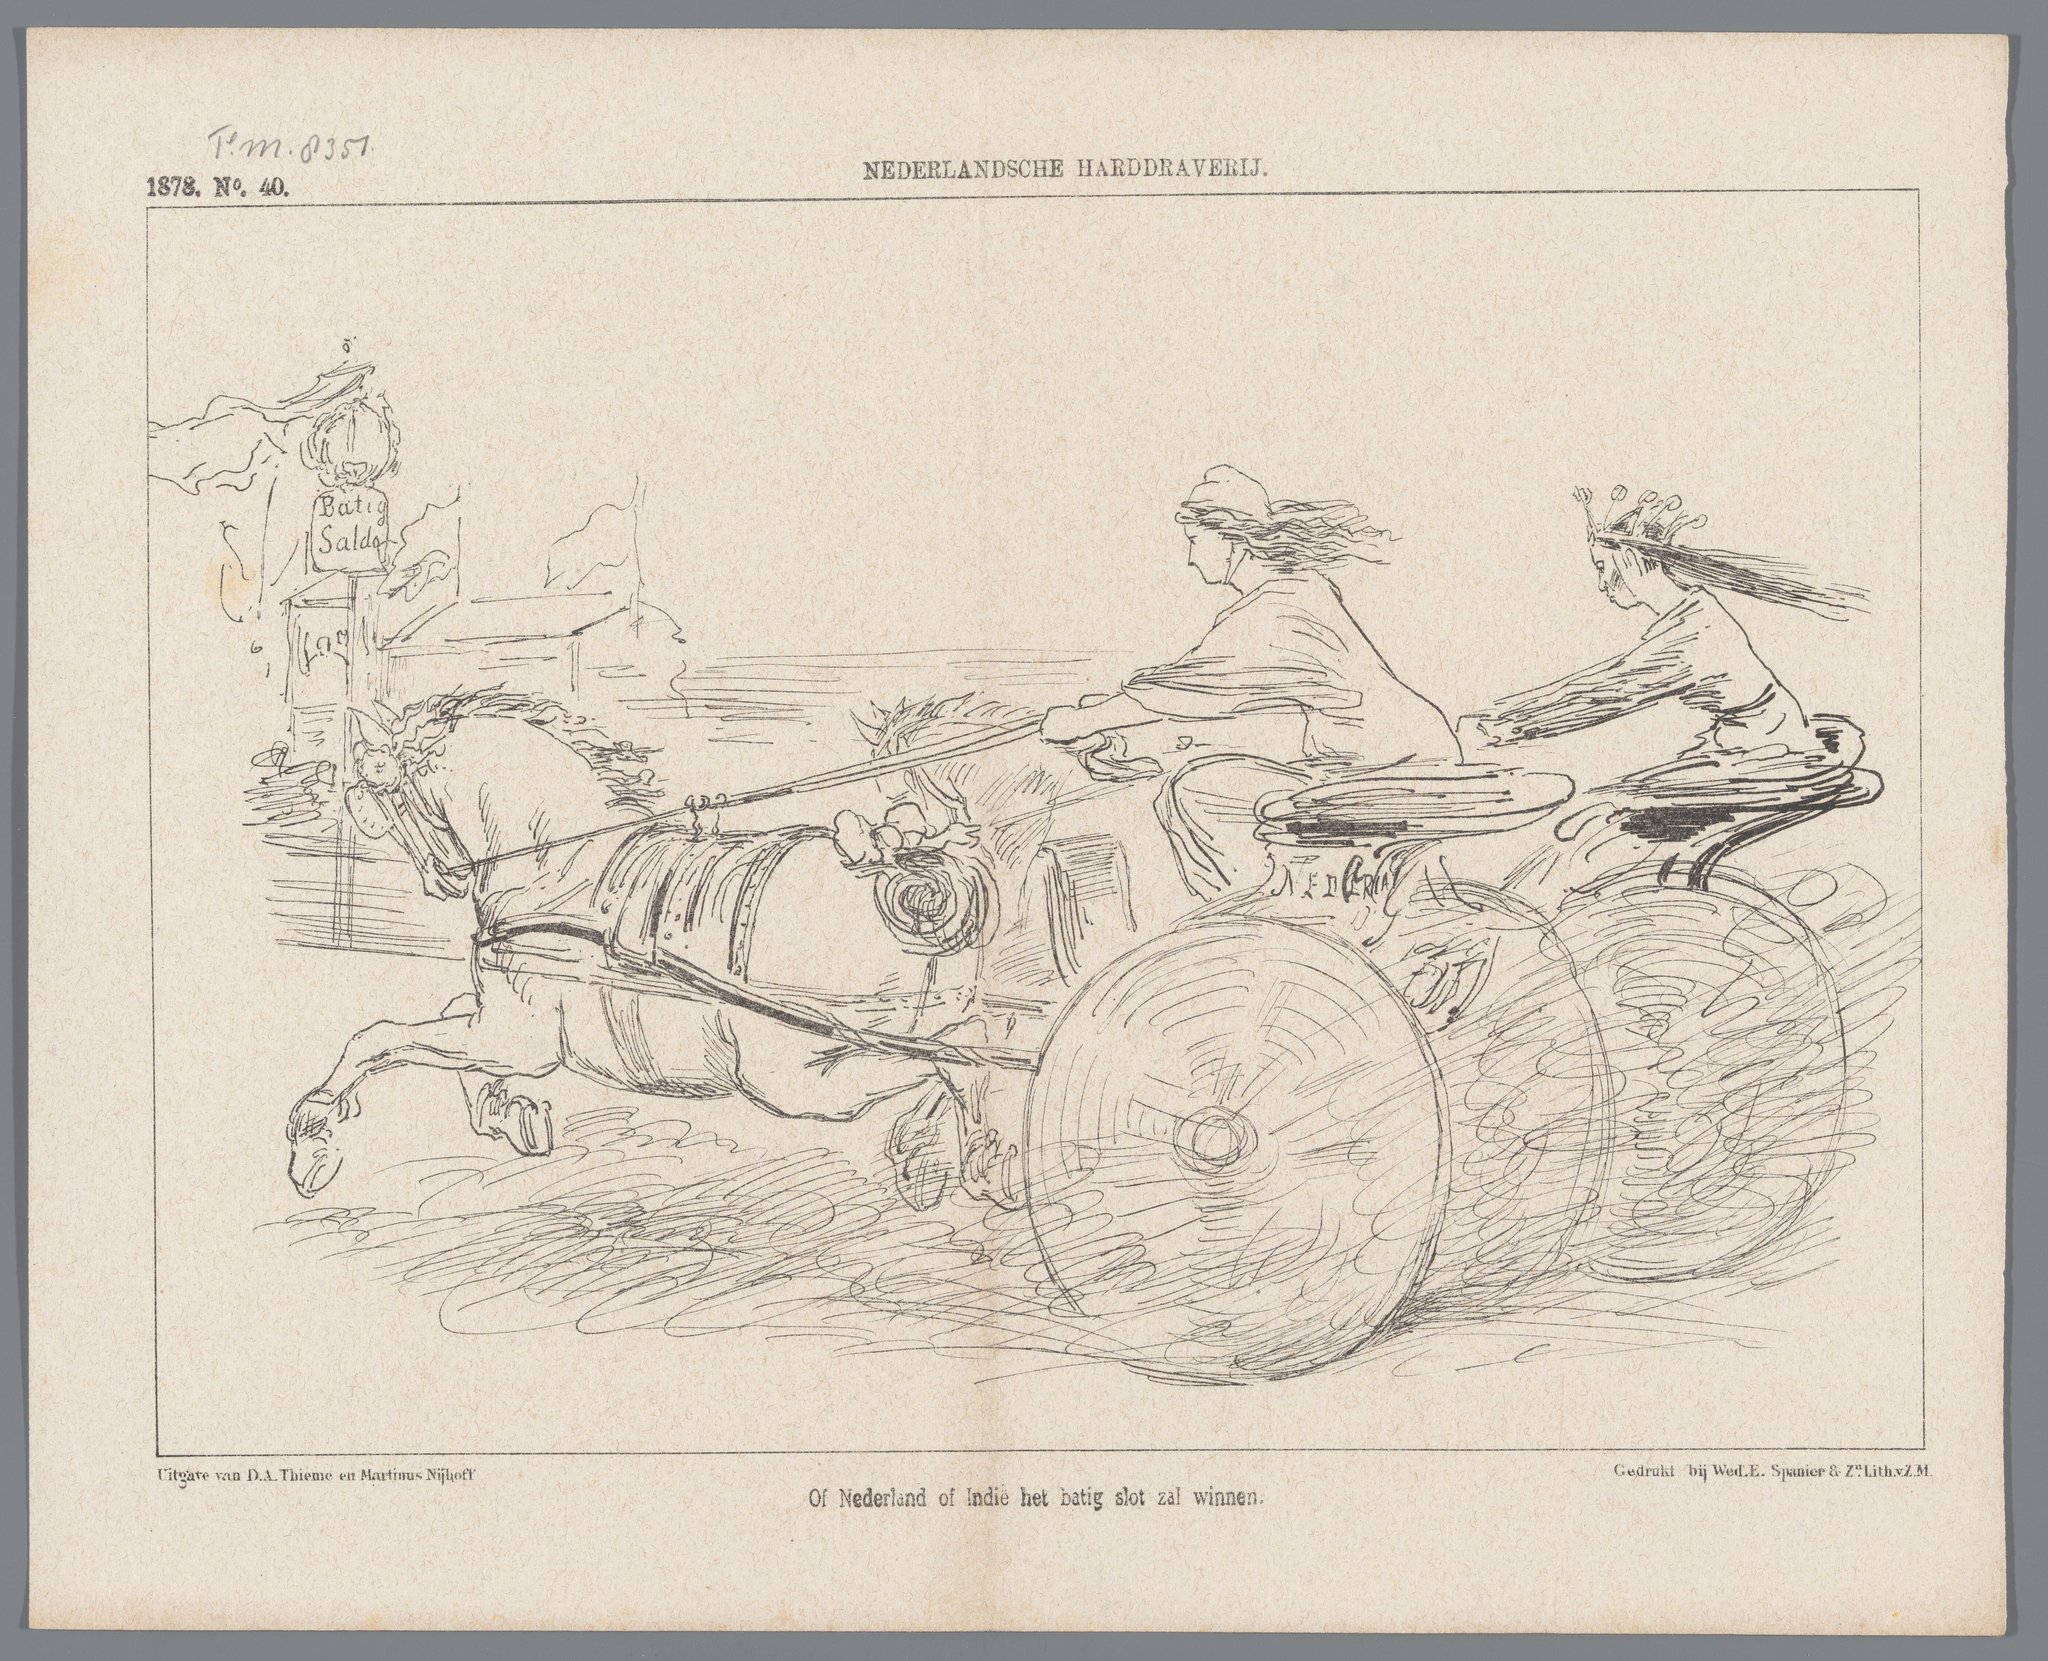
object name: cartoon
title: Nederlandsche harddraverij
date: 1878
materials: paper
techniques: lithograph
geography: netherlands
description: Spotprent. Plaat verschenen bij het weekblad De Nederlandsche Spectator, nr. 40, 1878.